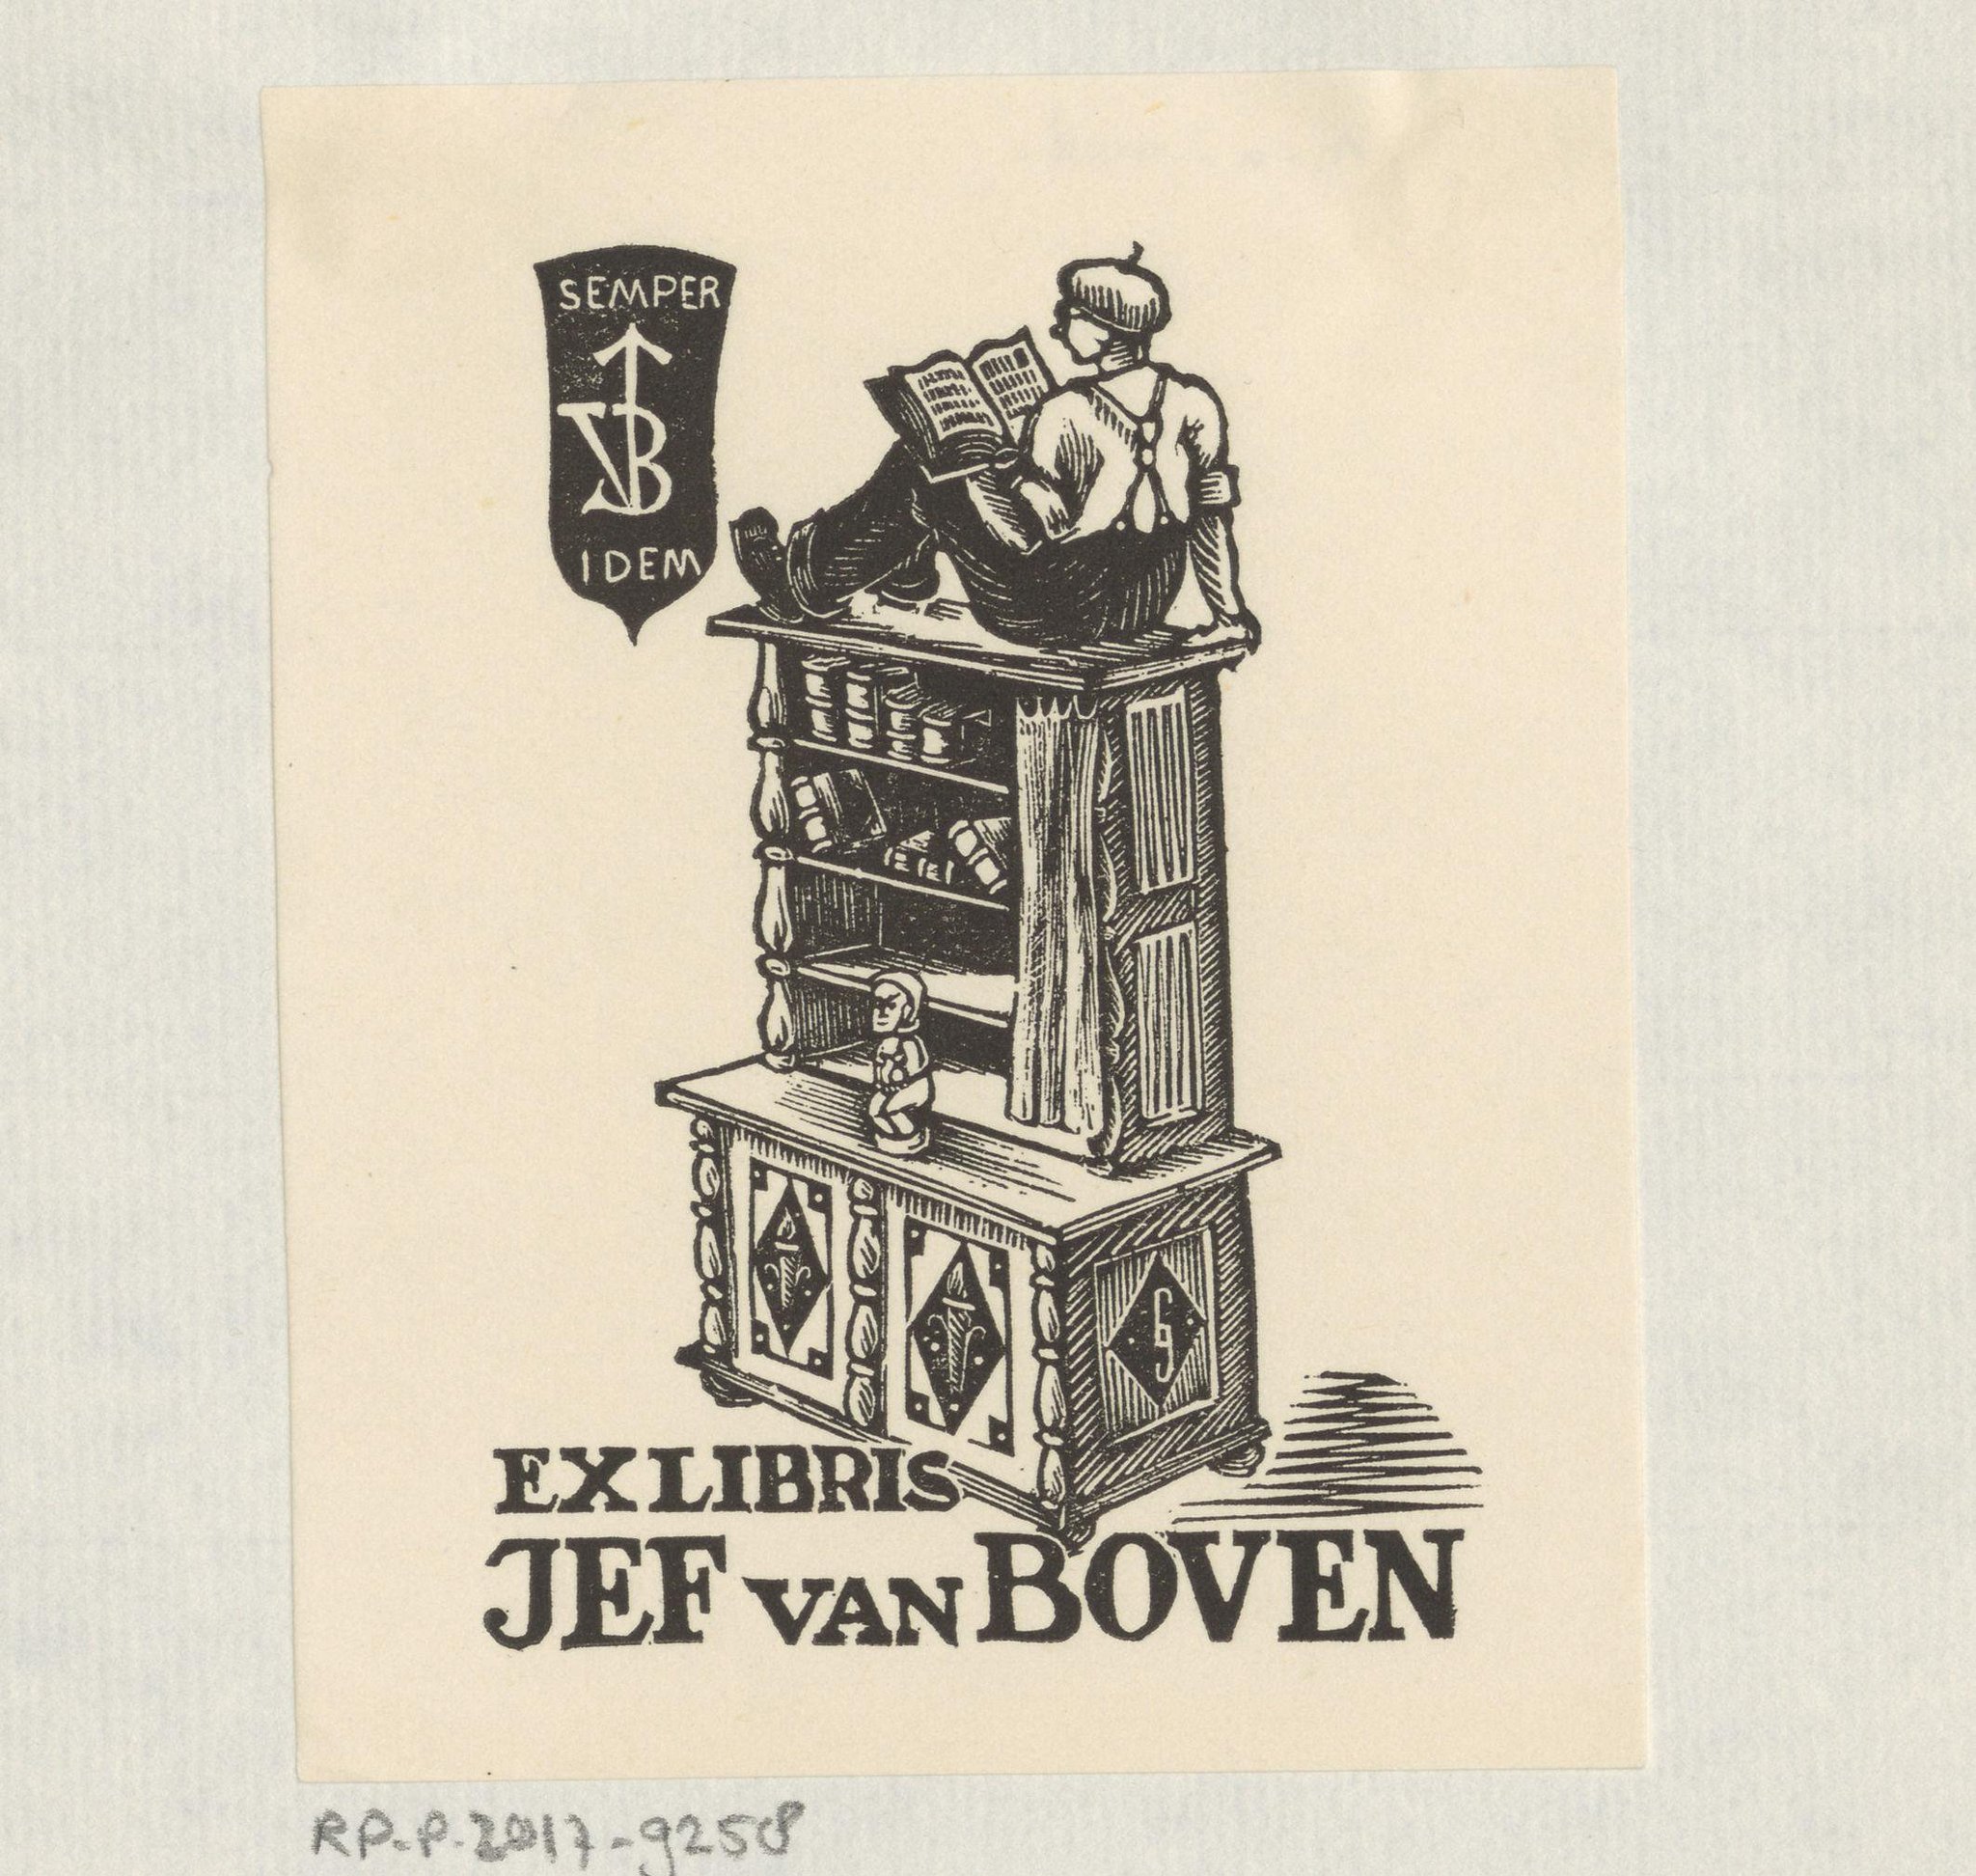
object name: bookplate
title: Ex libris van Jef van Boven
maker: josef leysen (jef)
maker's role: print maker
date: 1900-1999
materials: paper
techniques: woodcut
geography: belgium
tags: reading, cupboard